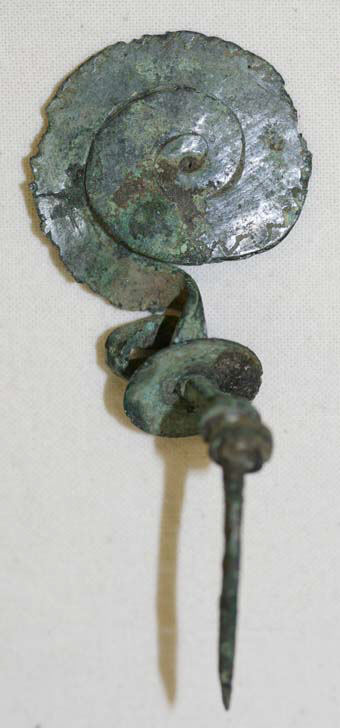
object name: pin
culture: european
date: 400-301 BCE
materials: bronze